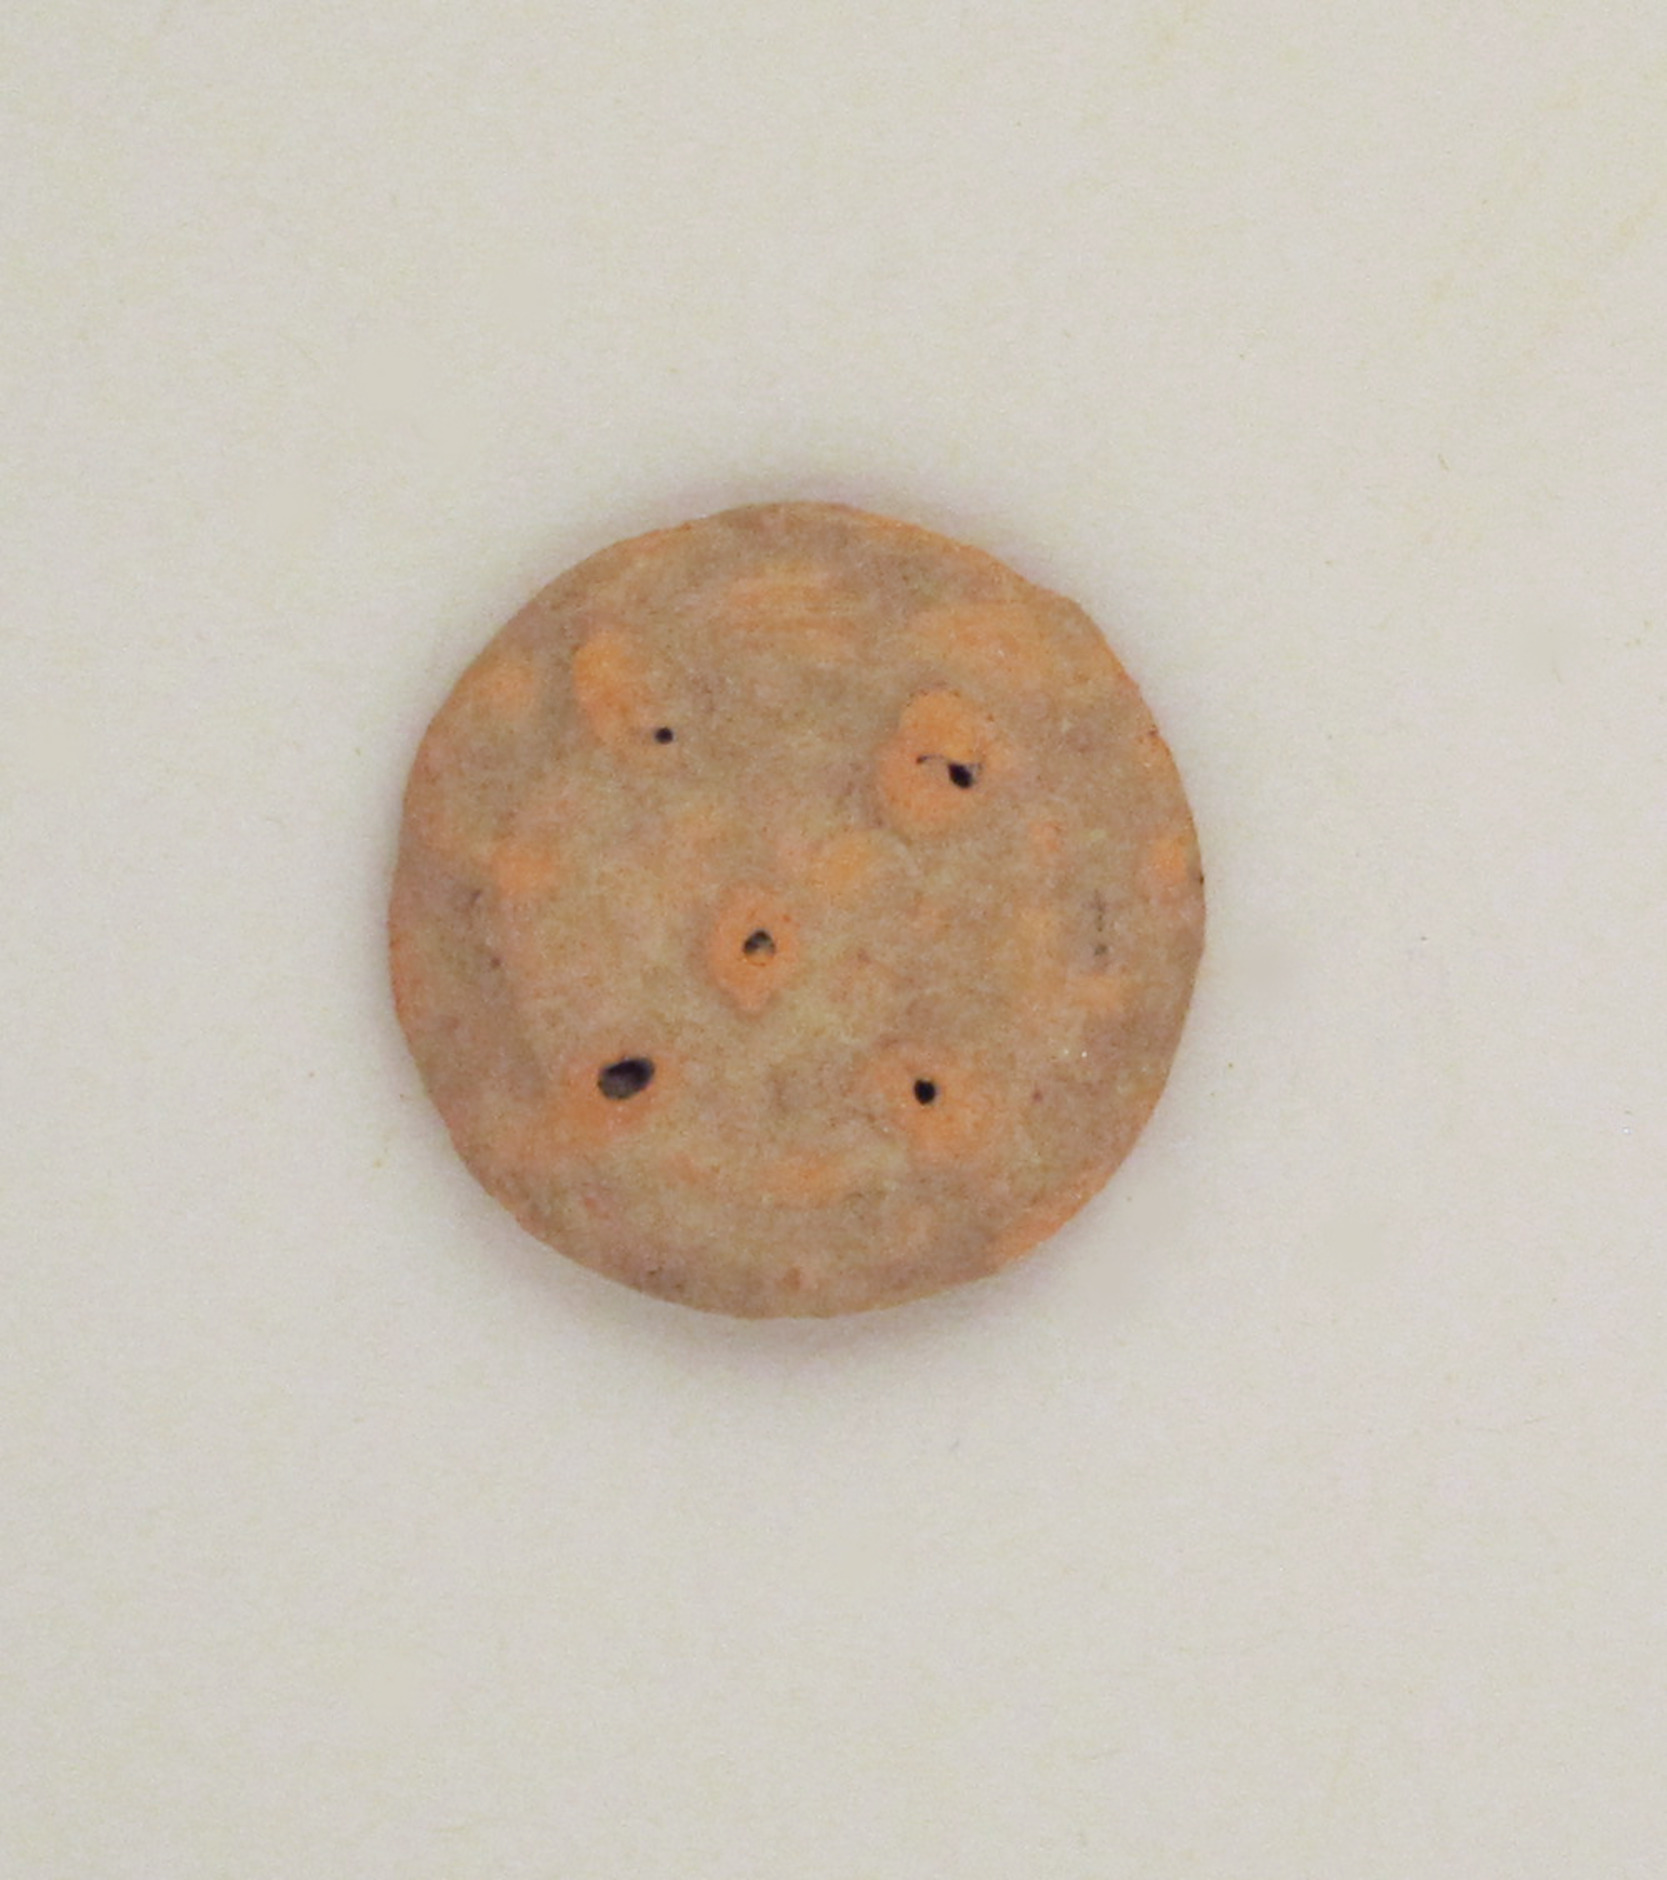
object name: plate, miniature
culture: greek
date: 7000-30 BCE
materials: terracotta